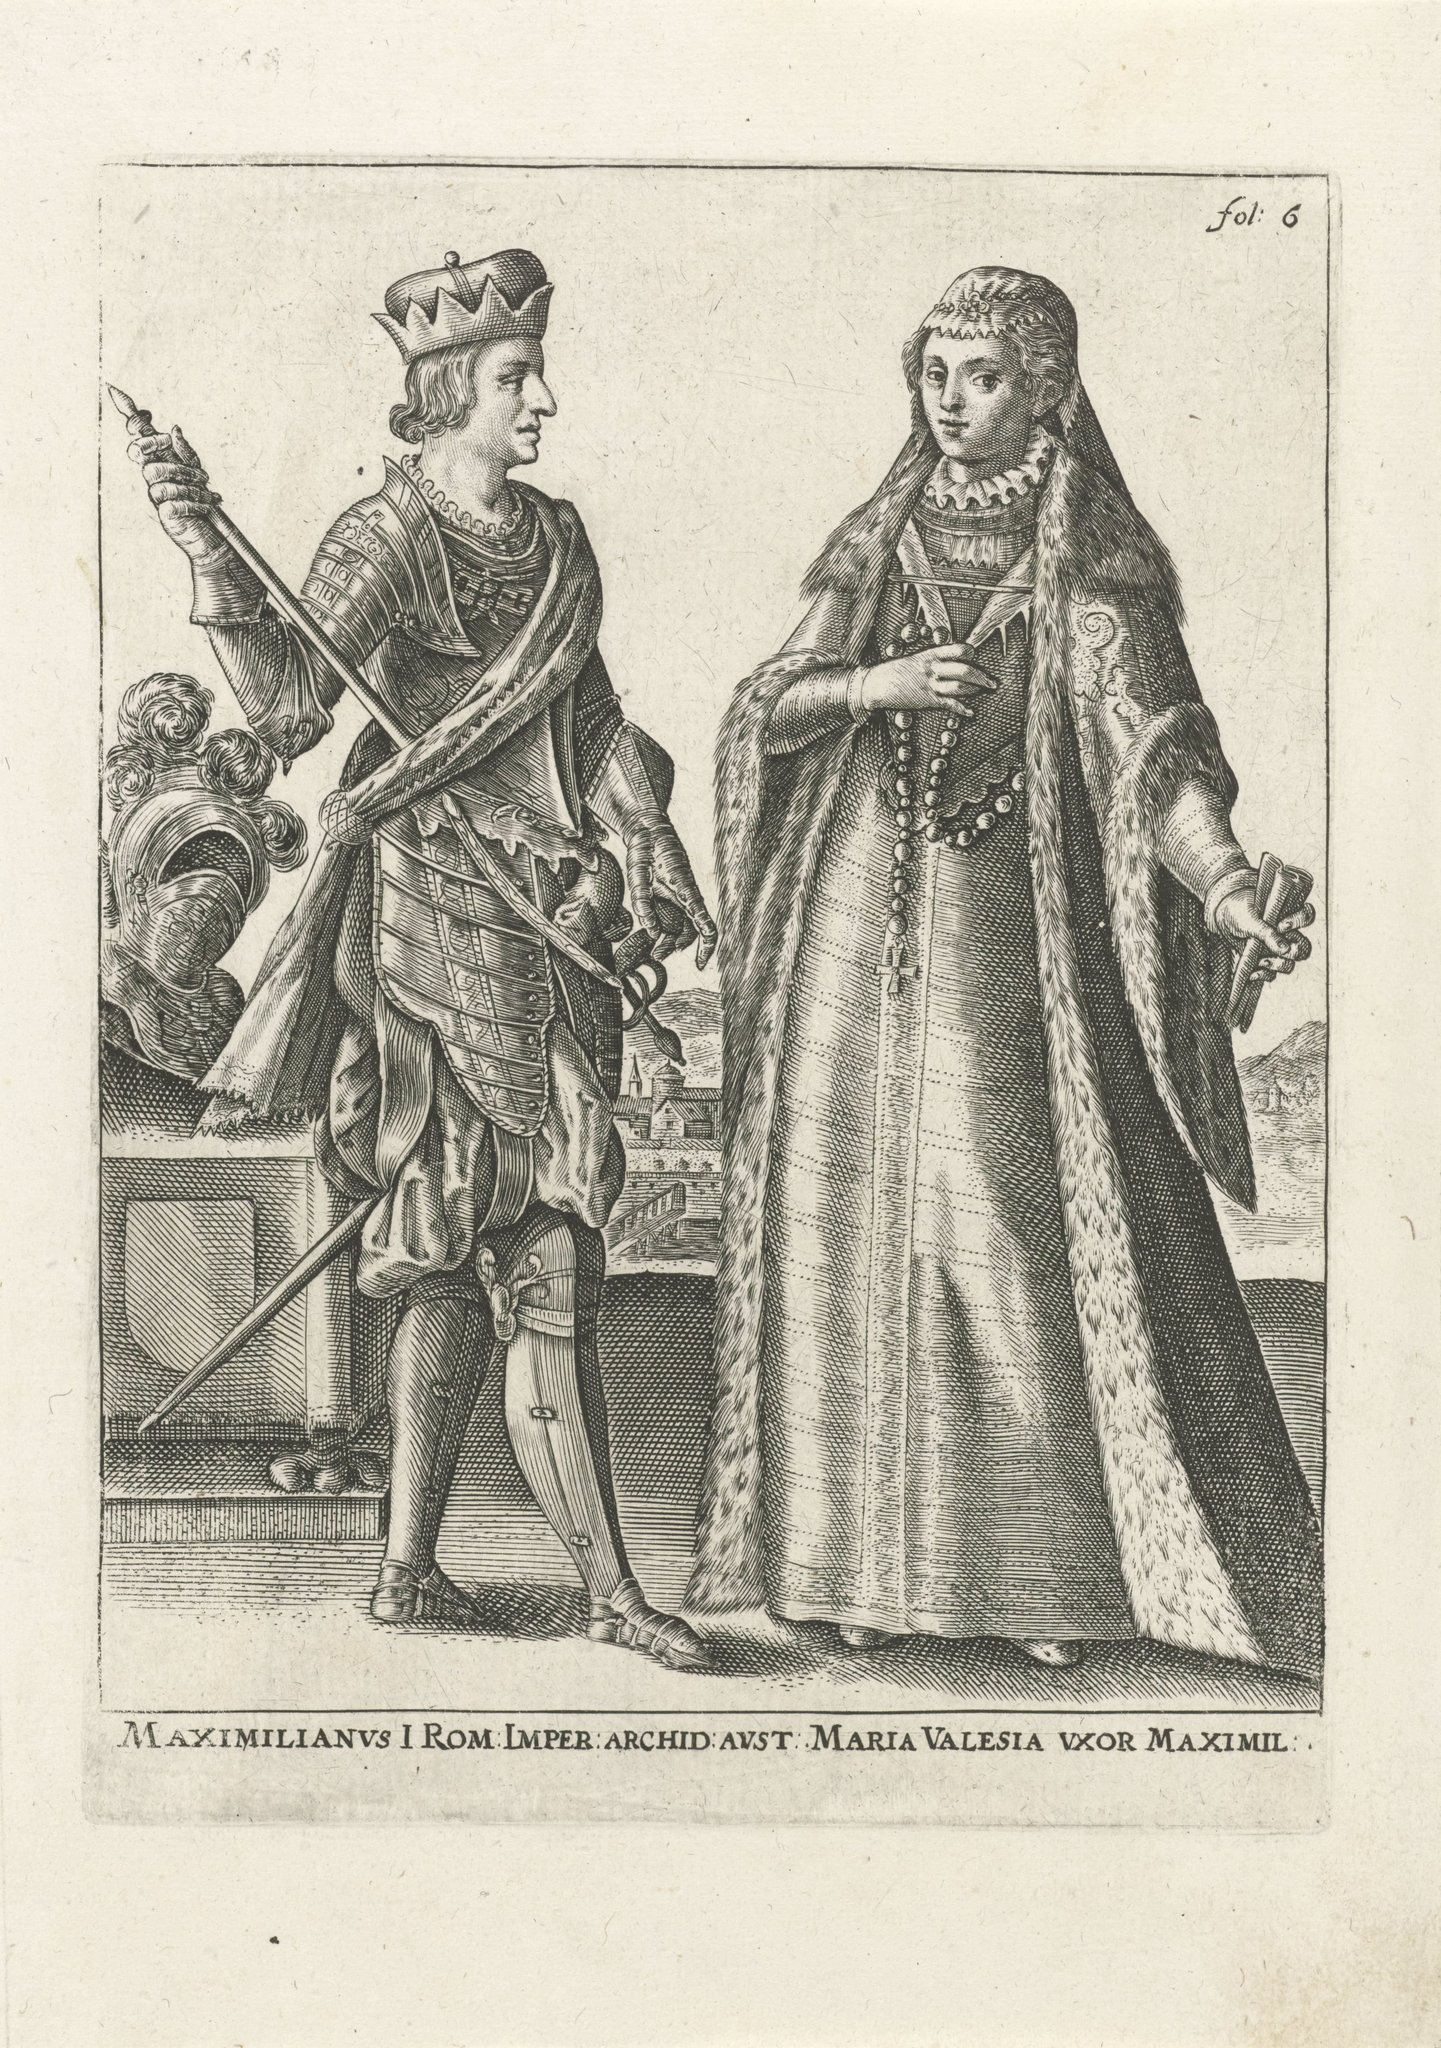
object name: print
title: Dubbelportret van keizer Maximiliaan I en Maria van Bourgondië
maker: simon van de passe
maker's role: print maker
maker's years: 1595-1647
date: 1605-1647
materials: paper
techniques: engraving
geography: northern netherlands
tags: brussels, bruges, maria (hertogin van bourgondië), maximilian i (holy roman emperor), historical persons - bb - woman, historical persons, emperor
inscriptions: collector's mark: Lugt 2228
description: Prent ook gebruikt in: Emanuel van Meteren, Historien der Nederlanden, en haar naburen oorlogen tot het jaar 1612 : met heerelijker konterfeijtsels dan ooyt voor dezen verciert en verbetert. Amsterdam: Jan Jacobsz Schipper, 1663.